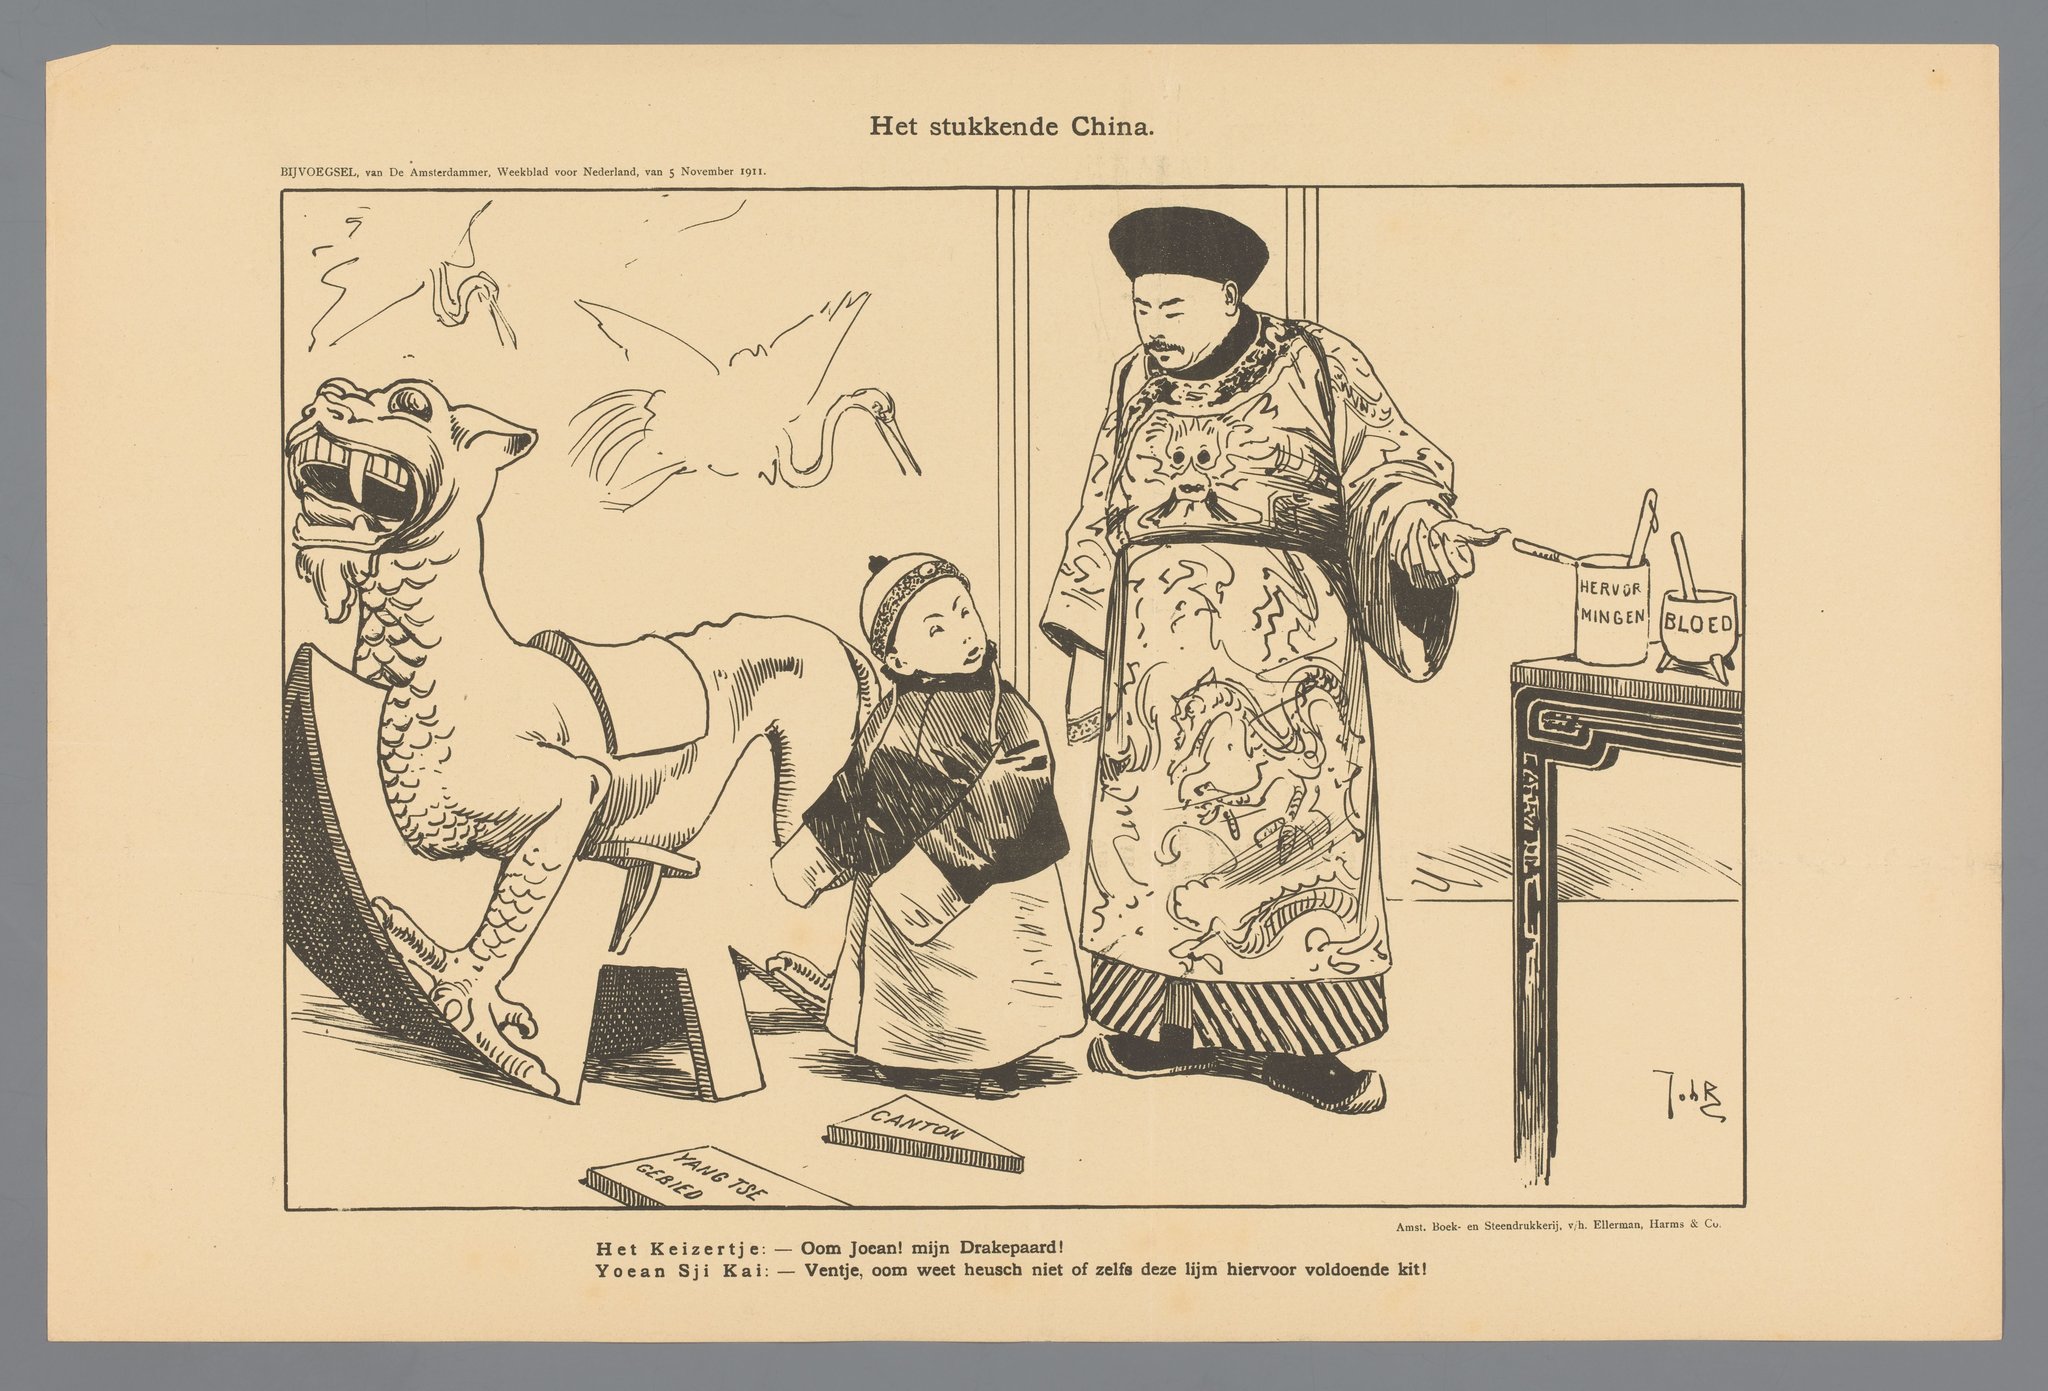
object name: cartoon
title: Het stukkende China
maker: johan braakensiek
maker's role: draughtsman, print maker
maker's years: 1858-1940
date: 1911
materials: paper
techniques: lithograph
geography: amsterdam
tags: president ~ head of republic, emperor, political caricatures and satires, china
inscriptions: date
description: Prent uit het bijvoegsel van: De Amsterdammer. Weekblad voor Nederland, 5 november 1911.